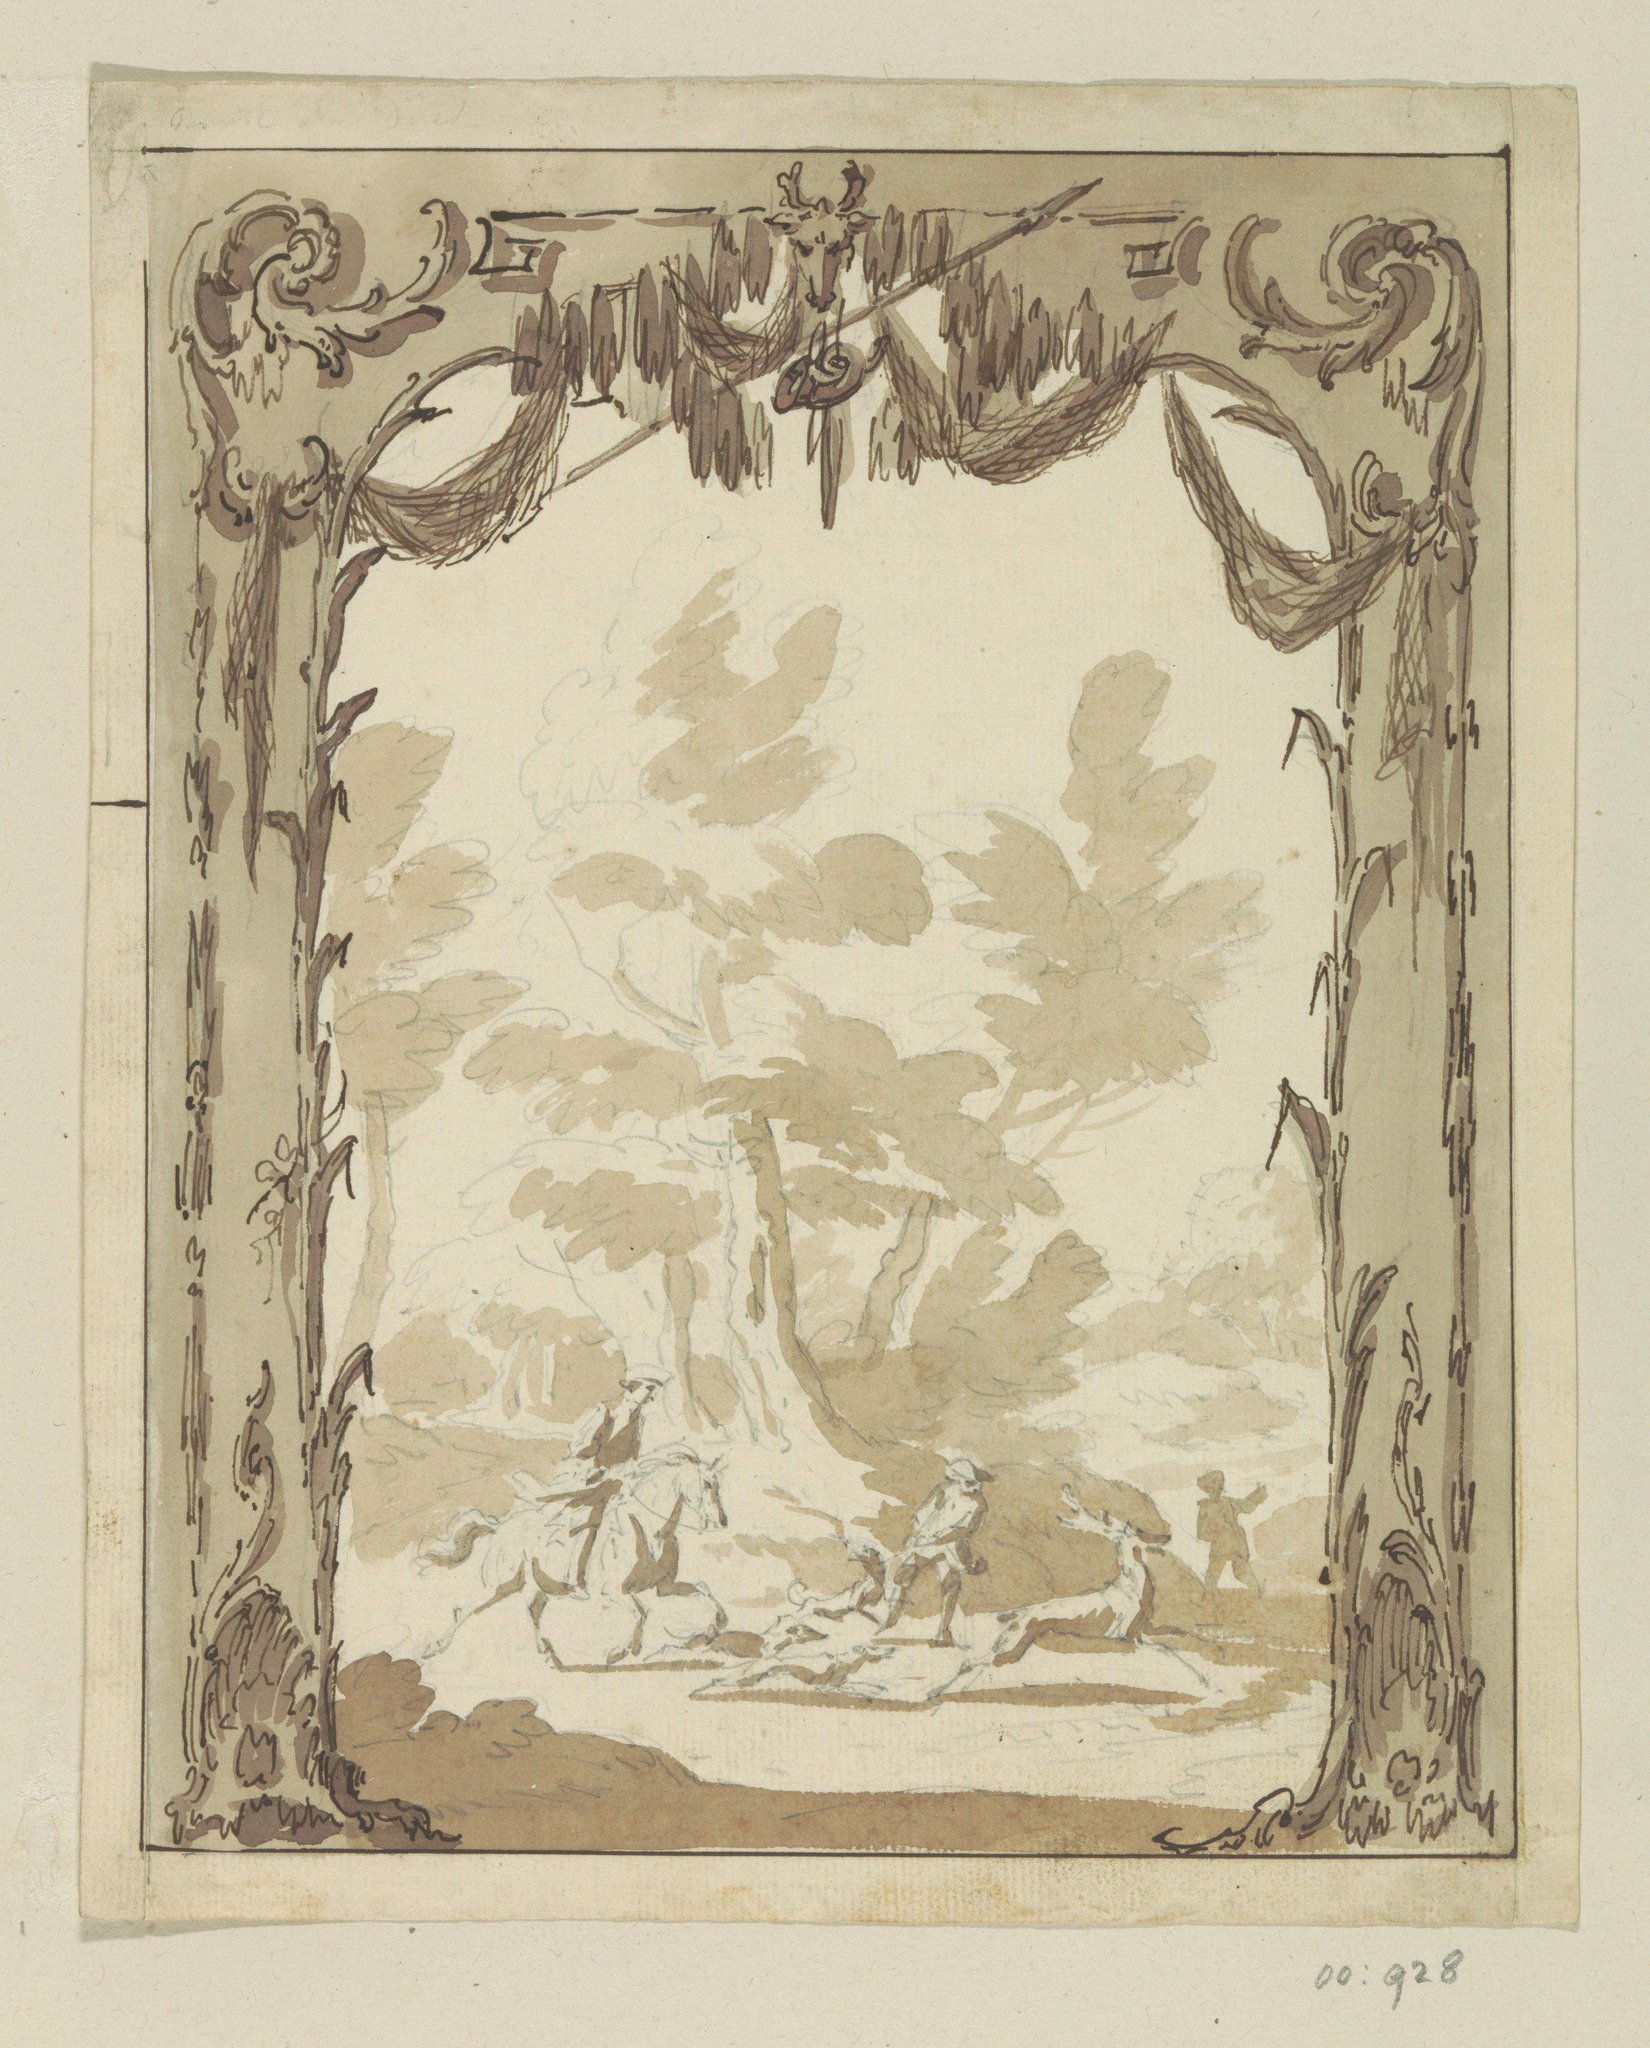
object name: album leaf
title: Hertenjacht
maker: Anonymous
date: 1760-1819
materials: ink, paper, pencil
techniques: brush, pen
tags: stag-hunting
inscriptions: inscription: ‘bovenaan inscriptie:/ naast de dier (?)/ alb[um] Andriessen/ fol 21’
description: Mogelijk ontwerp voor een wandtekening. Tekening maakt deel uit van een album, maar zit niet vastgeplakt op het albumblad.